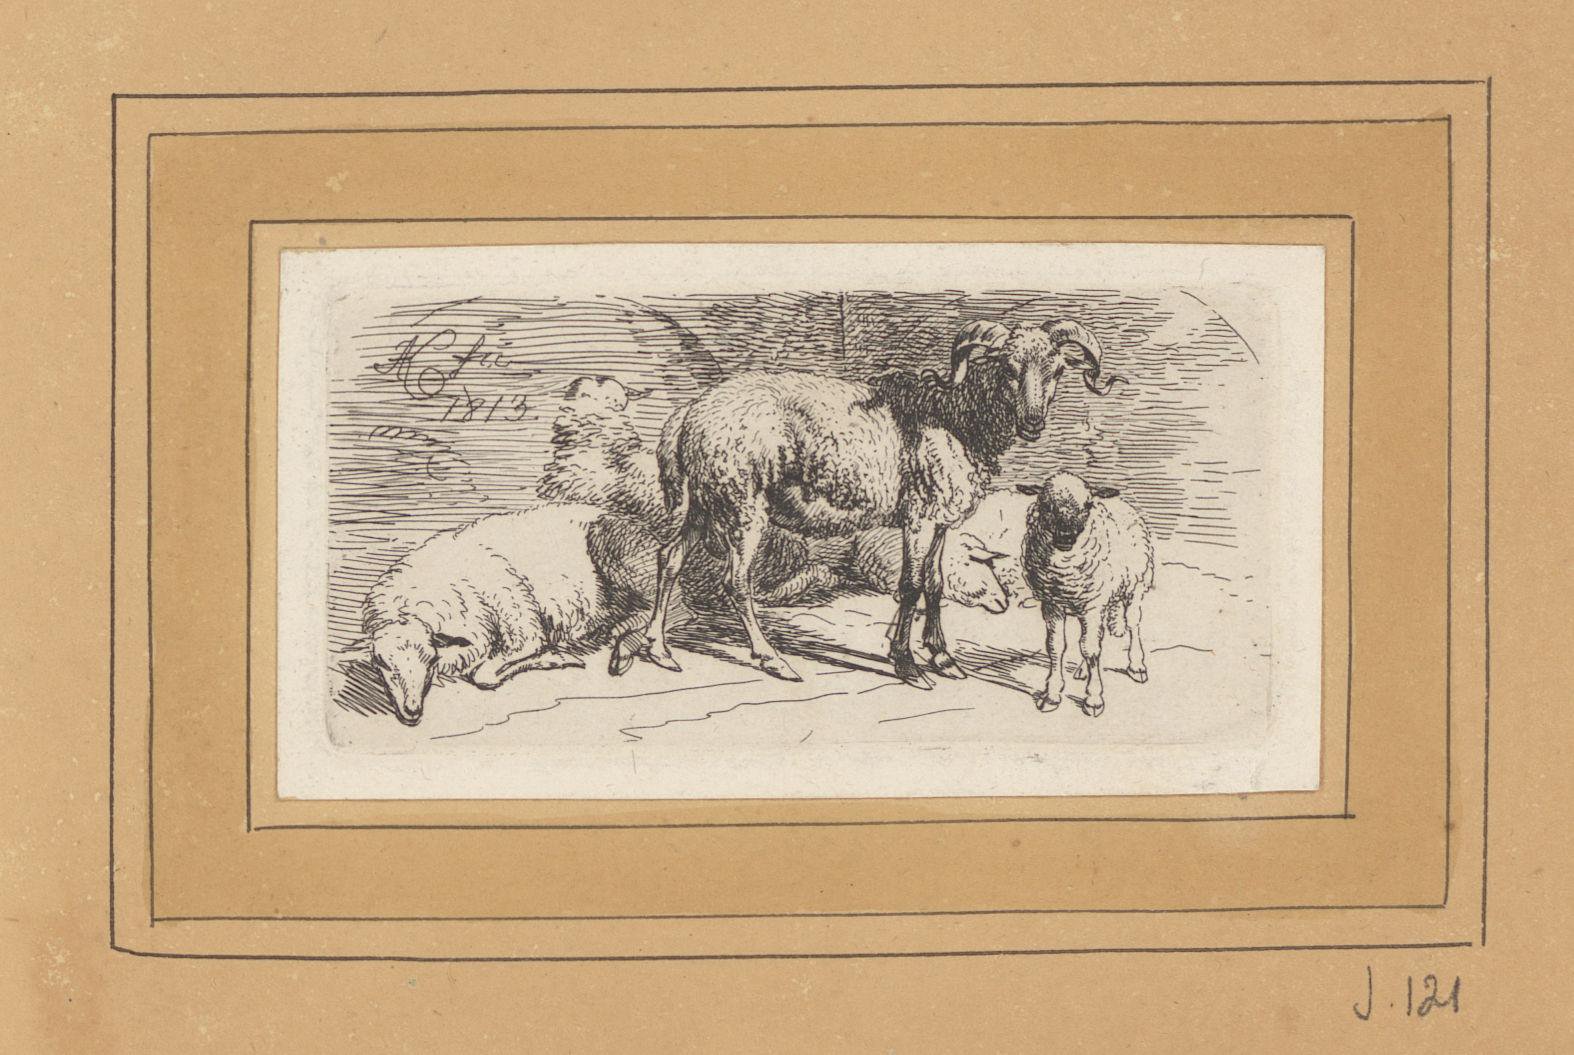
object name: album leaf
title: Ram met een lam en drie schapen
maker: johann adam klein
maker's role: draughtsman, print maker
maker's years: 1792-1875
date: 1813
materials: paper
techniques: etching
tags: ram, lamb, ewe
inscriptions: collector's mark: Lugt 2760, collector's mark: Lugt 2228